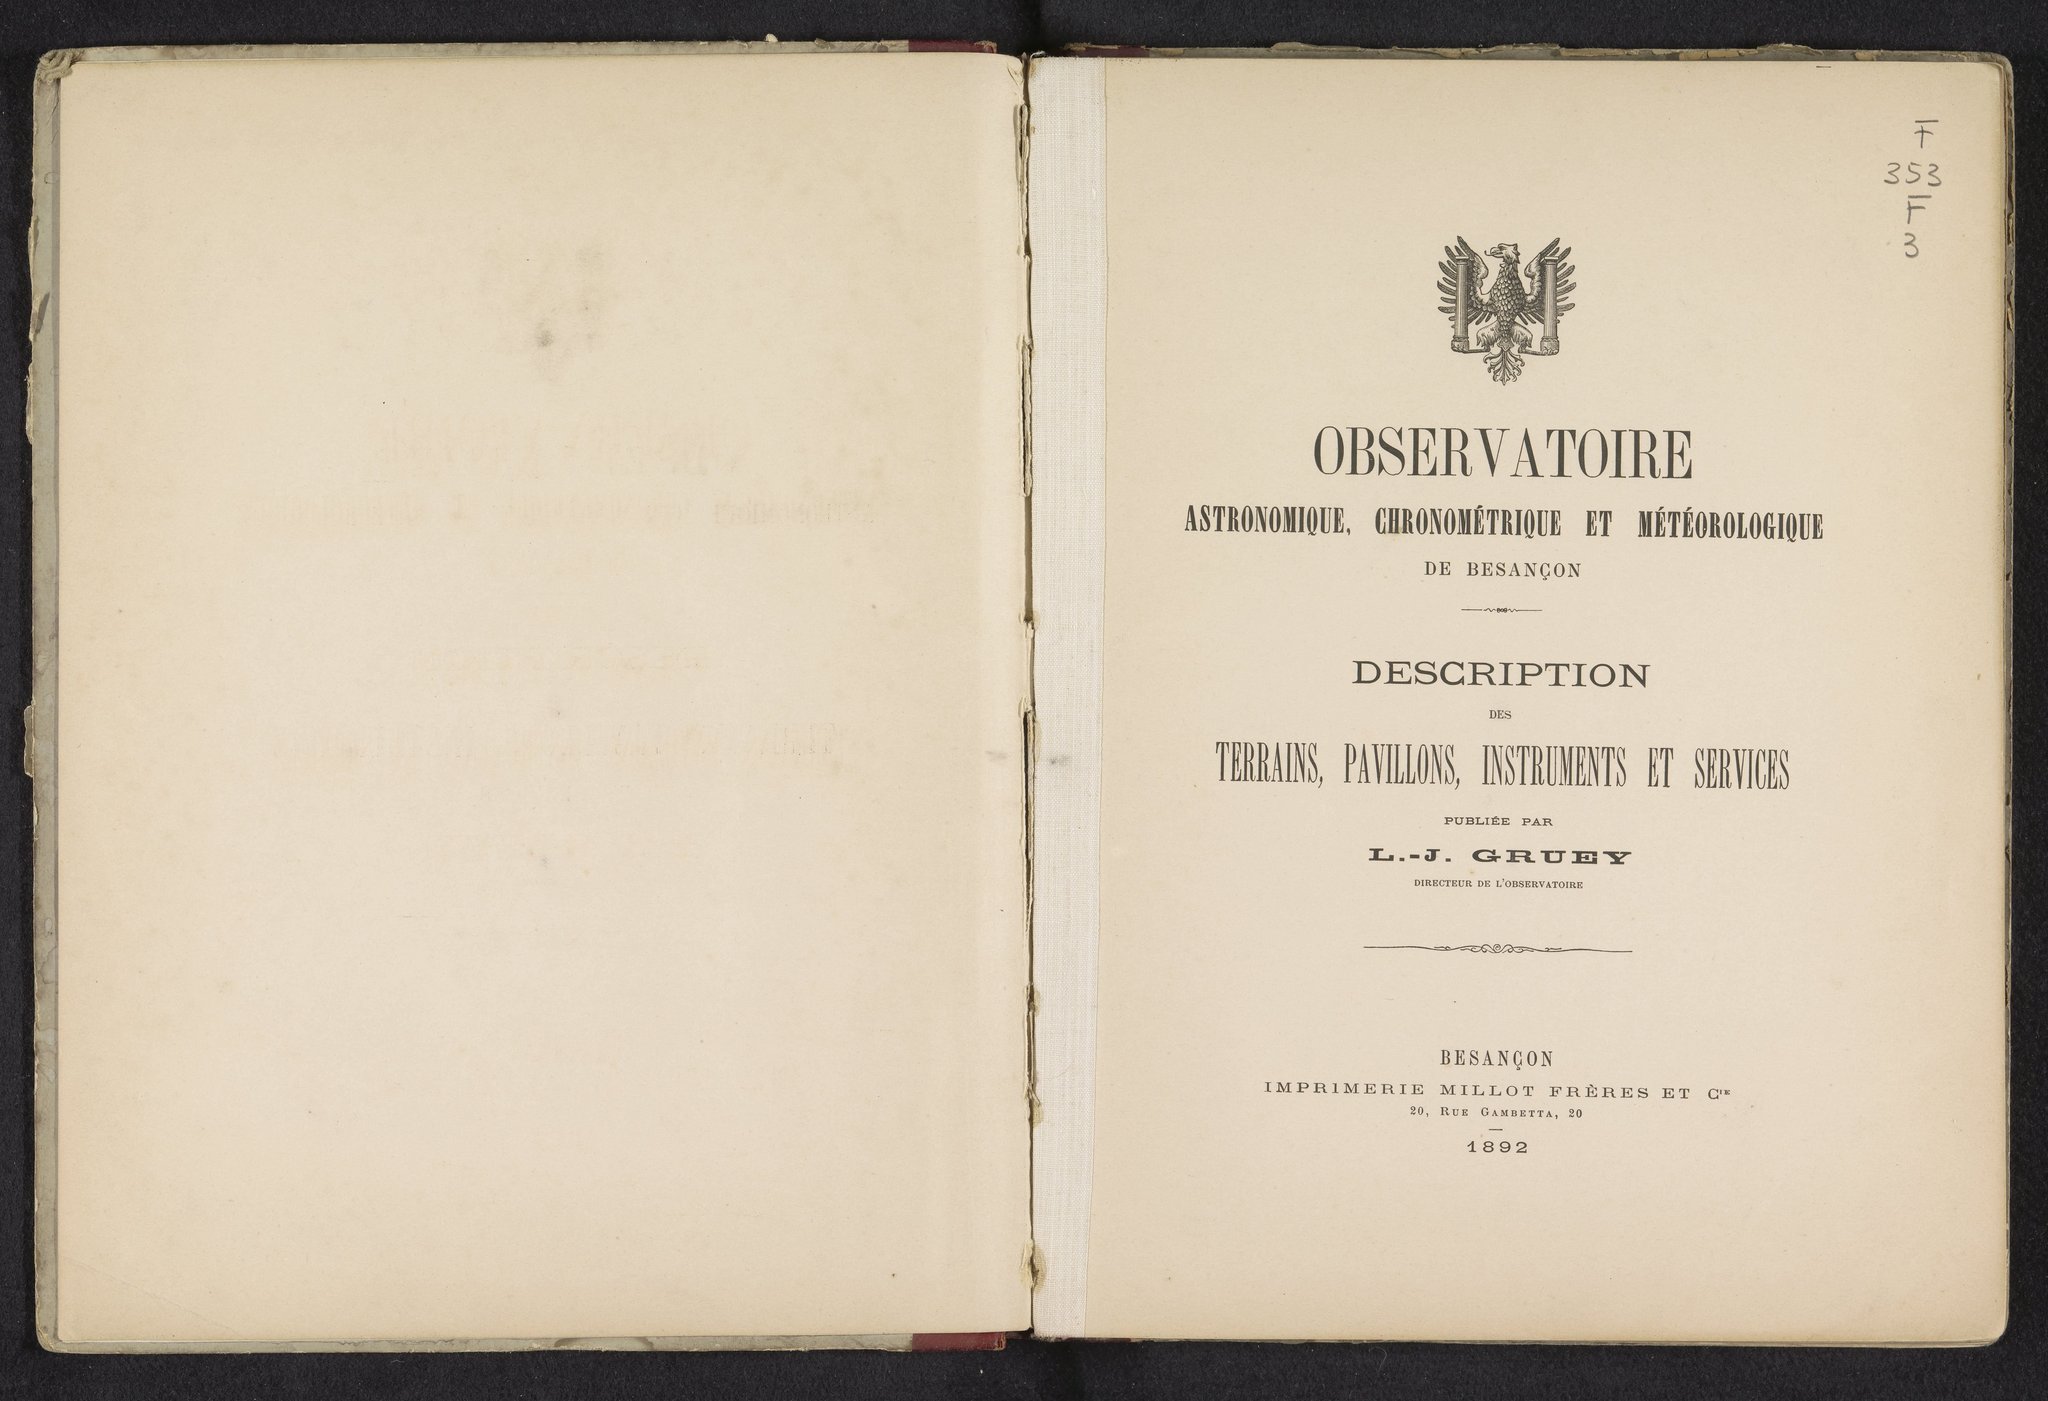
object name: book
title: Observatoire astronomique, chronométrique et météorologique de Besançon description des terrains, pavillons, instruments et services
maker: louis jules gruey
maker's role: astronoom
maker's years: 1837-1902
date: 1892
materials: cardboard, leather, paper, photographic support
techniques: albumen print, lithograph, printing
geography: besançon